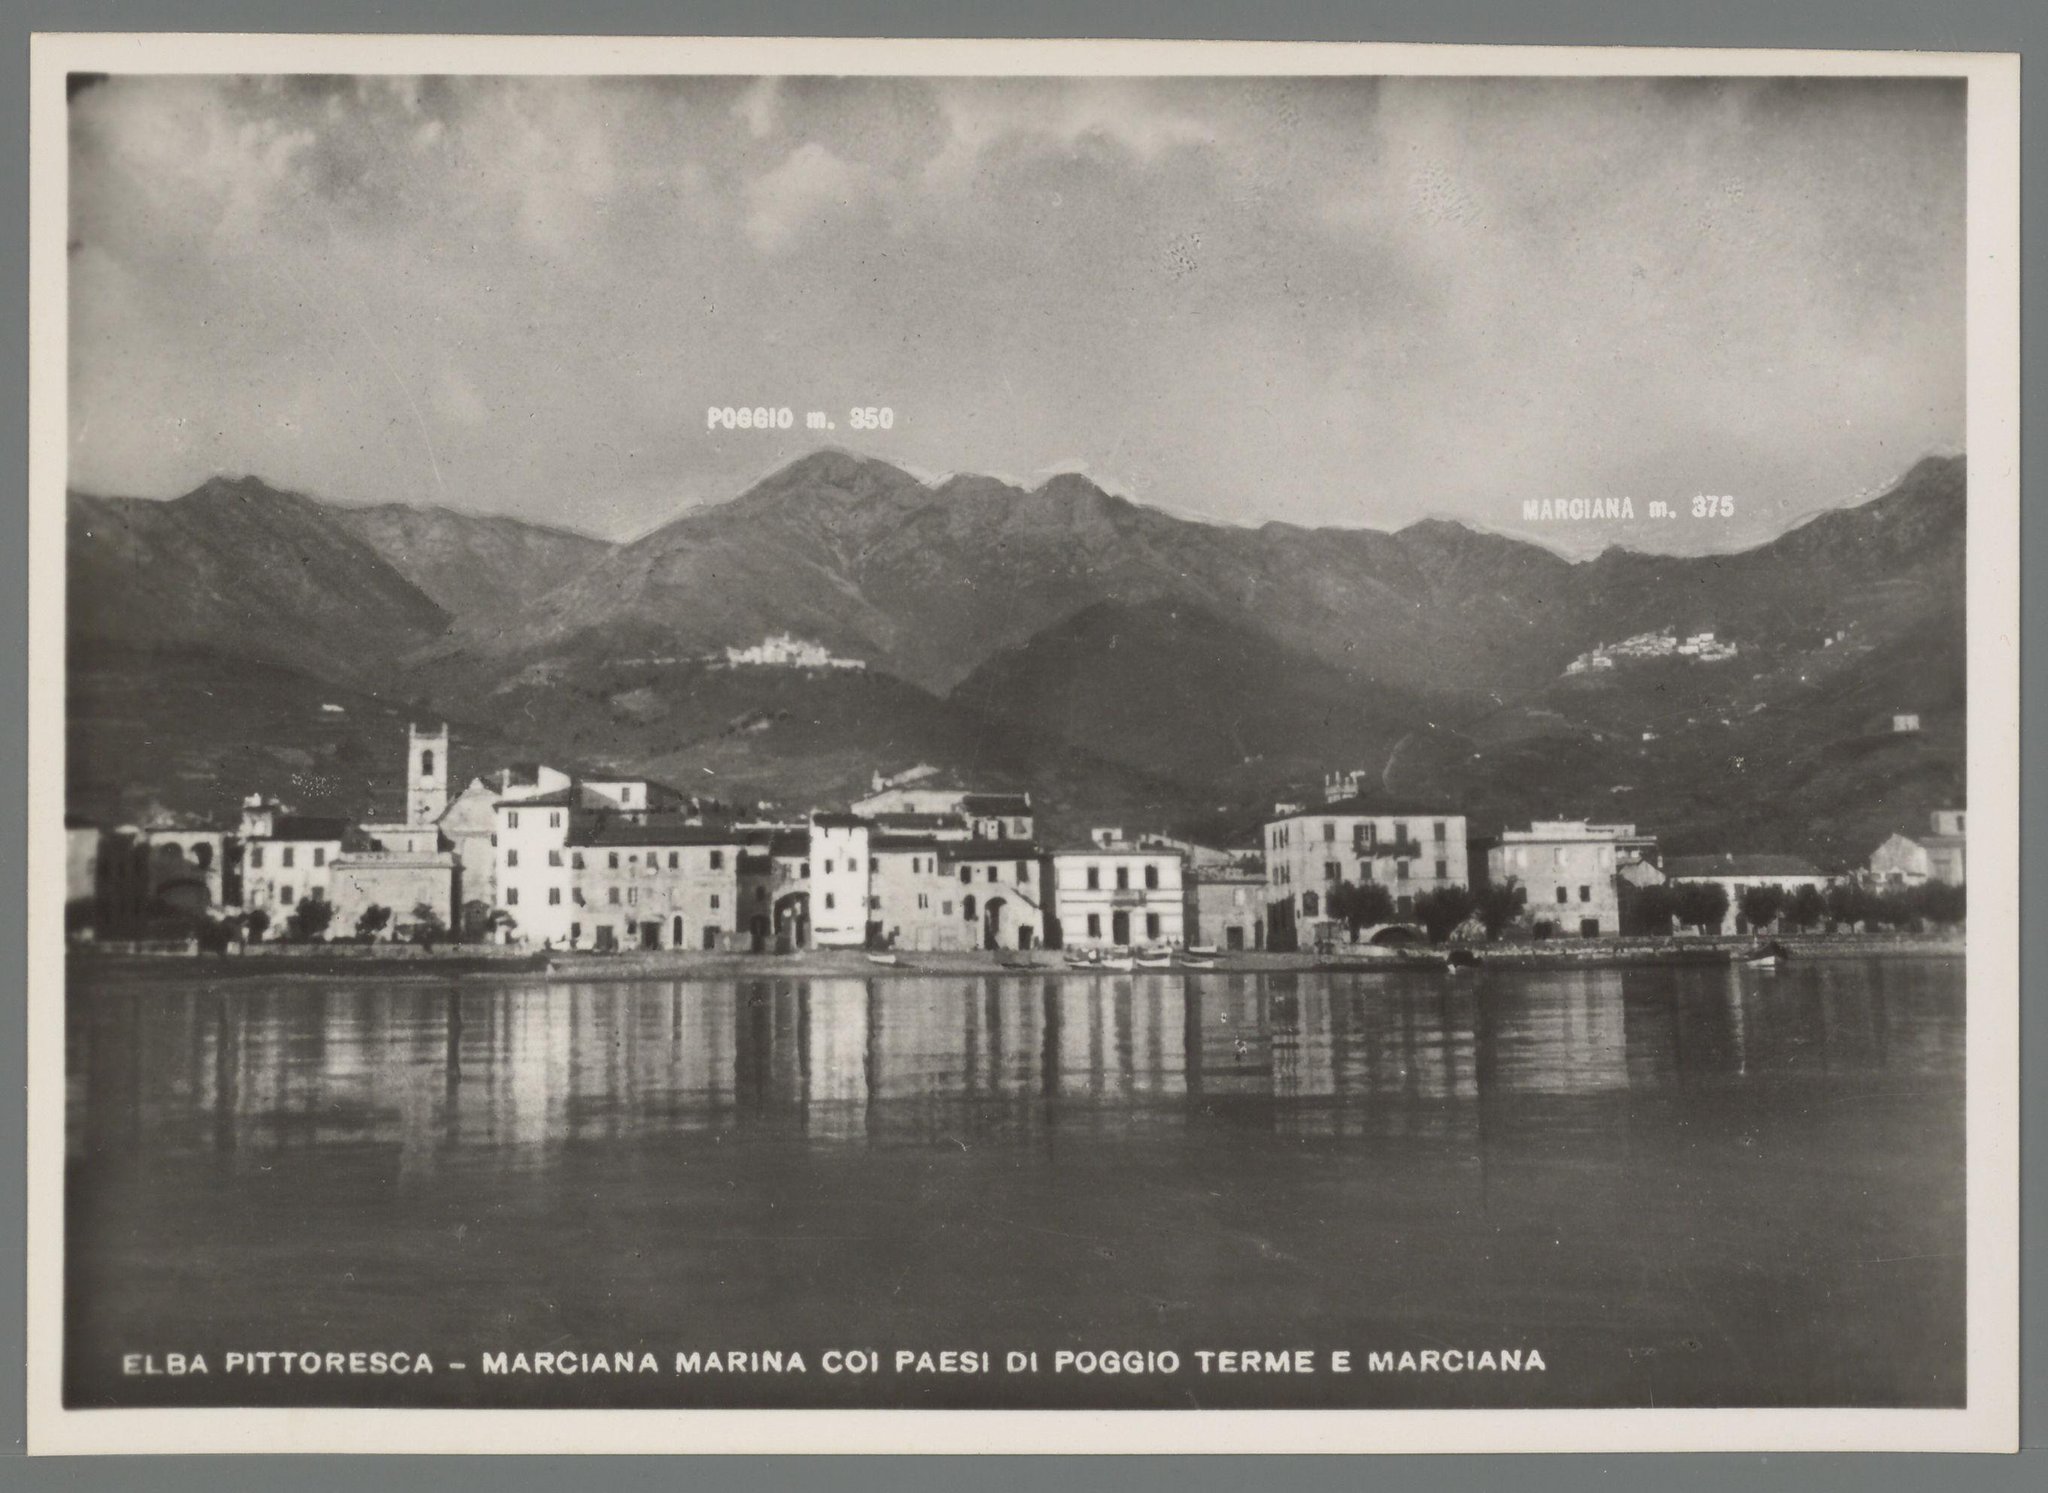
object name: ansichtkaart, prentbriefkaart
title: Elba Pittoresca. Marciana Marina coi paesi di Poggio Terme e Marciana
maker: Anonymous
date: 1935-1938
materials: photographic support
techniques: photography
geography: marciana marina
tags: prospect of village, silhouette of village, island, coast